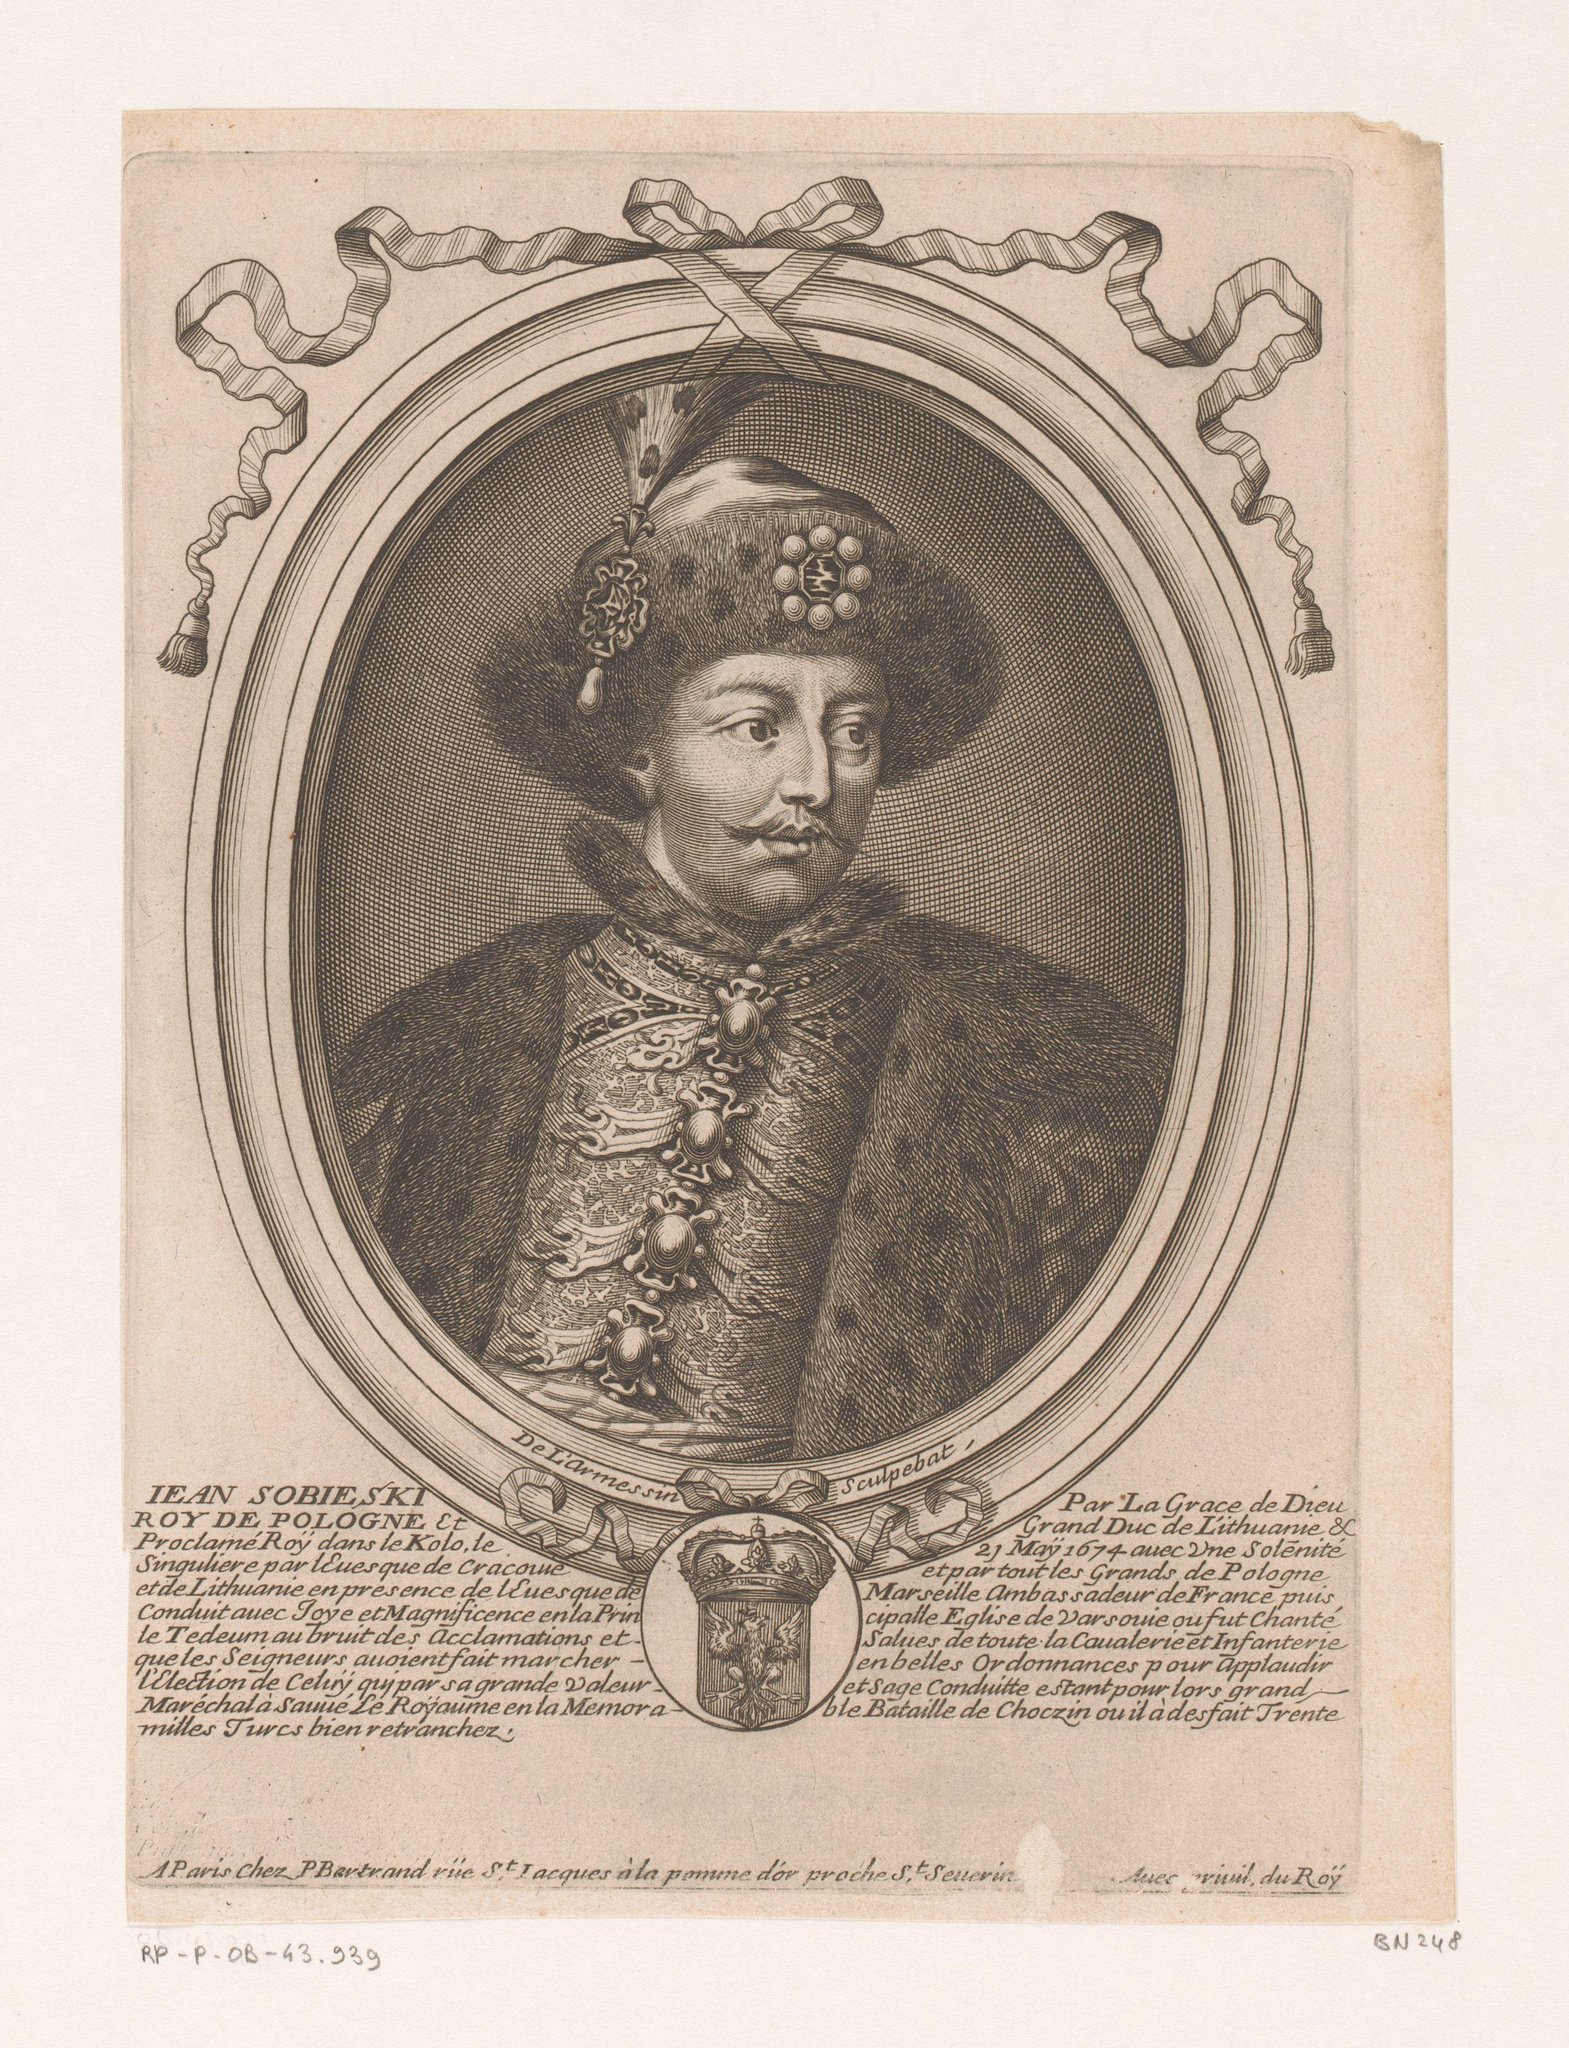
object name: print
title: Jean Sobieski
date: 1642-1678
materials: paper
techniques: engraving, etching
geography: france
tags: historical persons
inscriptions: collector's mark: Lugt 2228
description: Maakt deel uit van een grootschalige serie met portretten van prominente figuren. Binnen de serie bevindt zich een sectie getiteld 'Les Augustes Représentations De tous les Roys De France depuis Pharamond Iusqu'à Louys XIIII'. De serie werd respectievelijk uitgegeven door Pierre Bertrand, door zijn weduwe en door De Larmessin zelf.